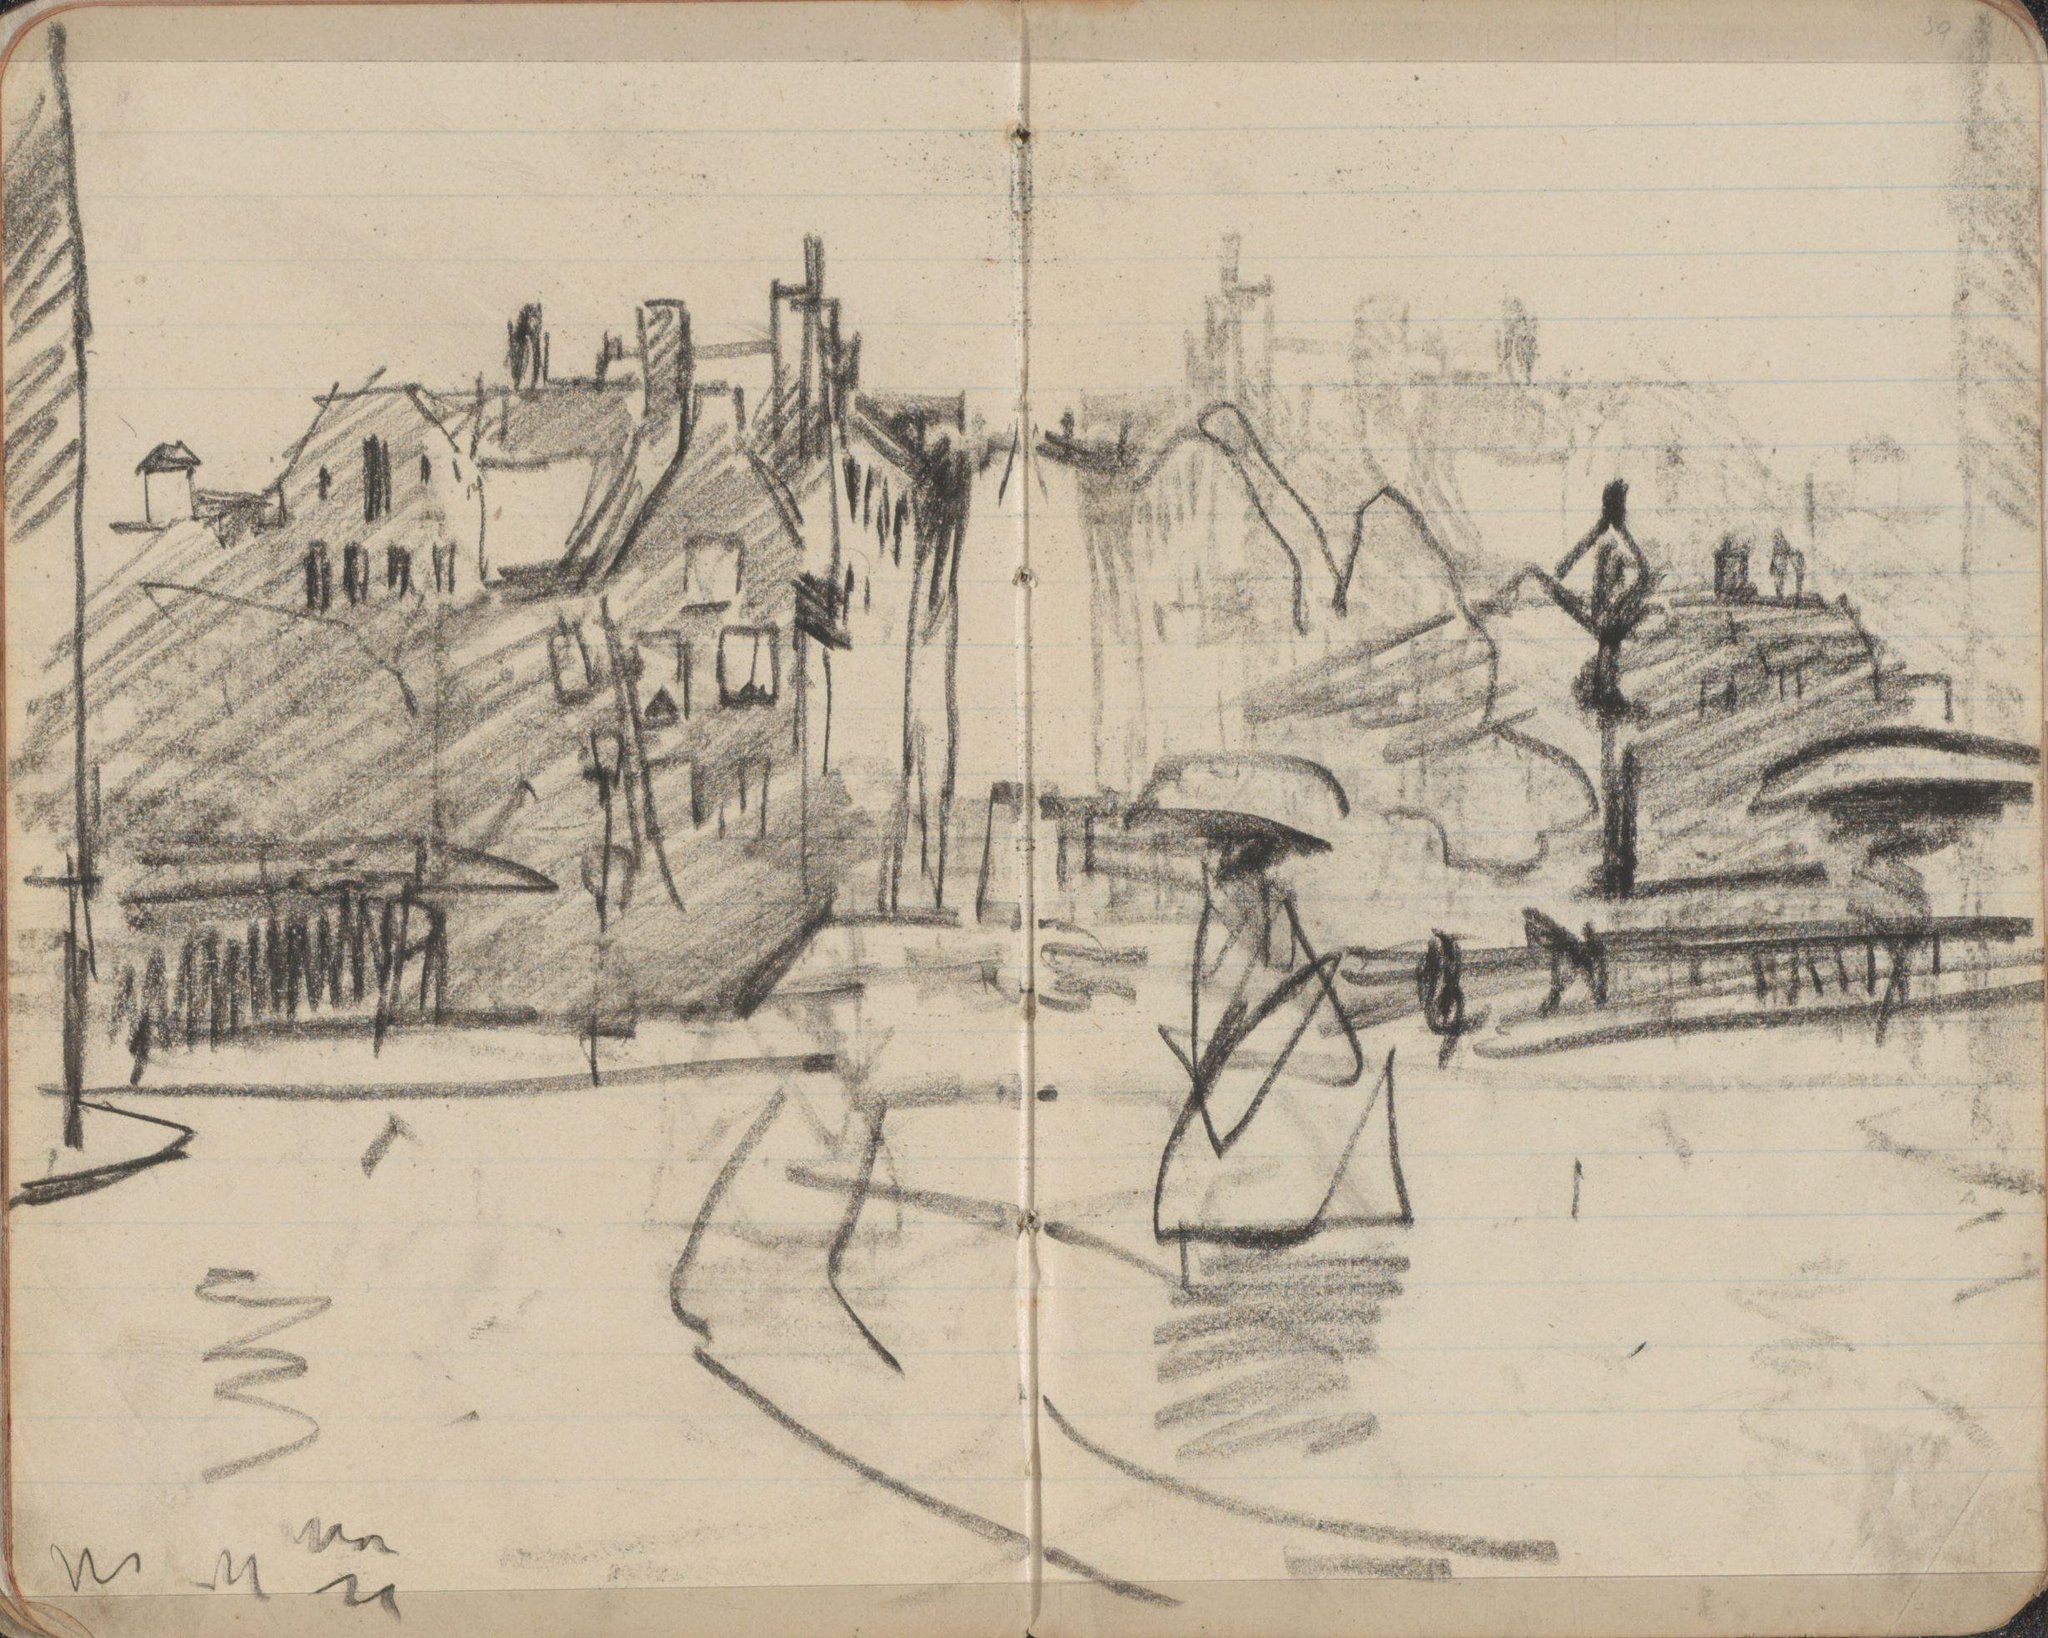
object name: sketchbook leaf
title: Gezicht in Amsterdam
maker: george hendrik breitner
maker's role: draughtsman, painter, print maker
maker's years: 1857-1923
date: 1893-1894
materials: chalk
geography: amsterdam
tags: civic architecture; edifices; dwellings, street (+ city(-scape) with figures, staffage), amsterdam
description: Vooraan een vrouw onder een paraplu. Pagina 38 en pagina 39 uit een schetsboek met 36 bladen.